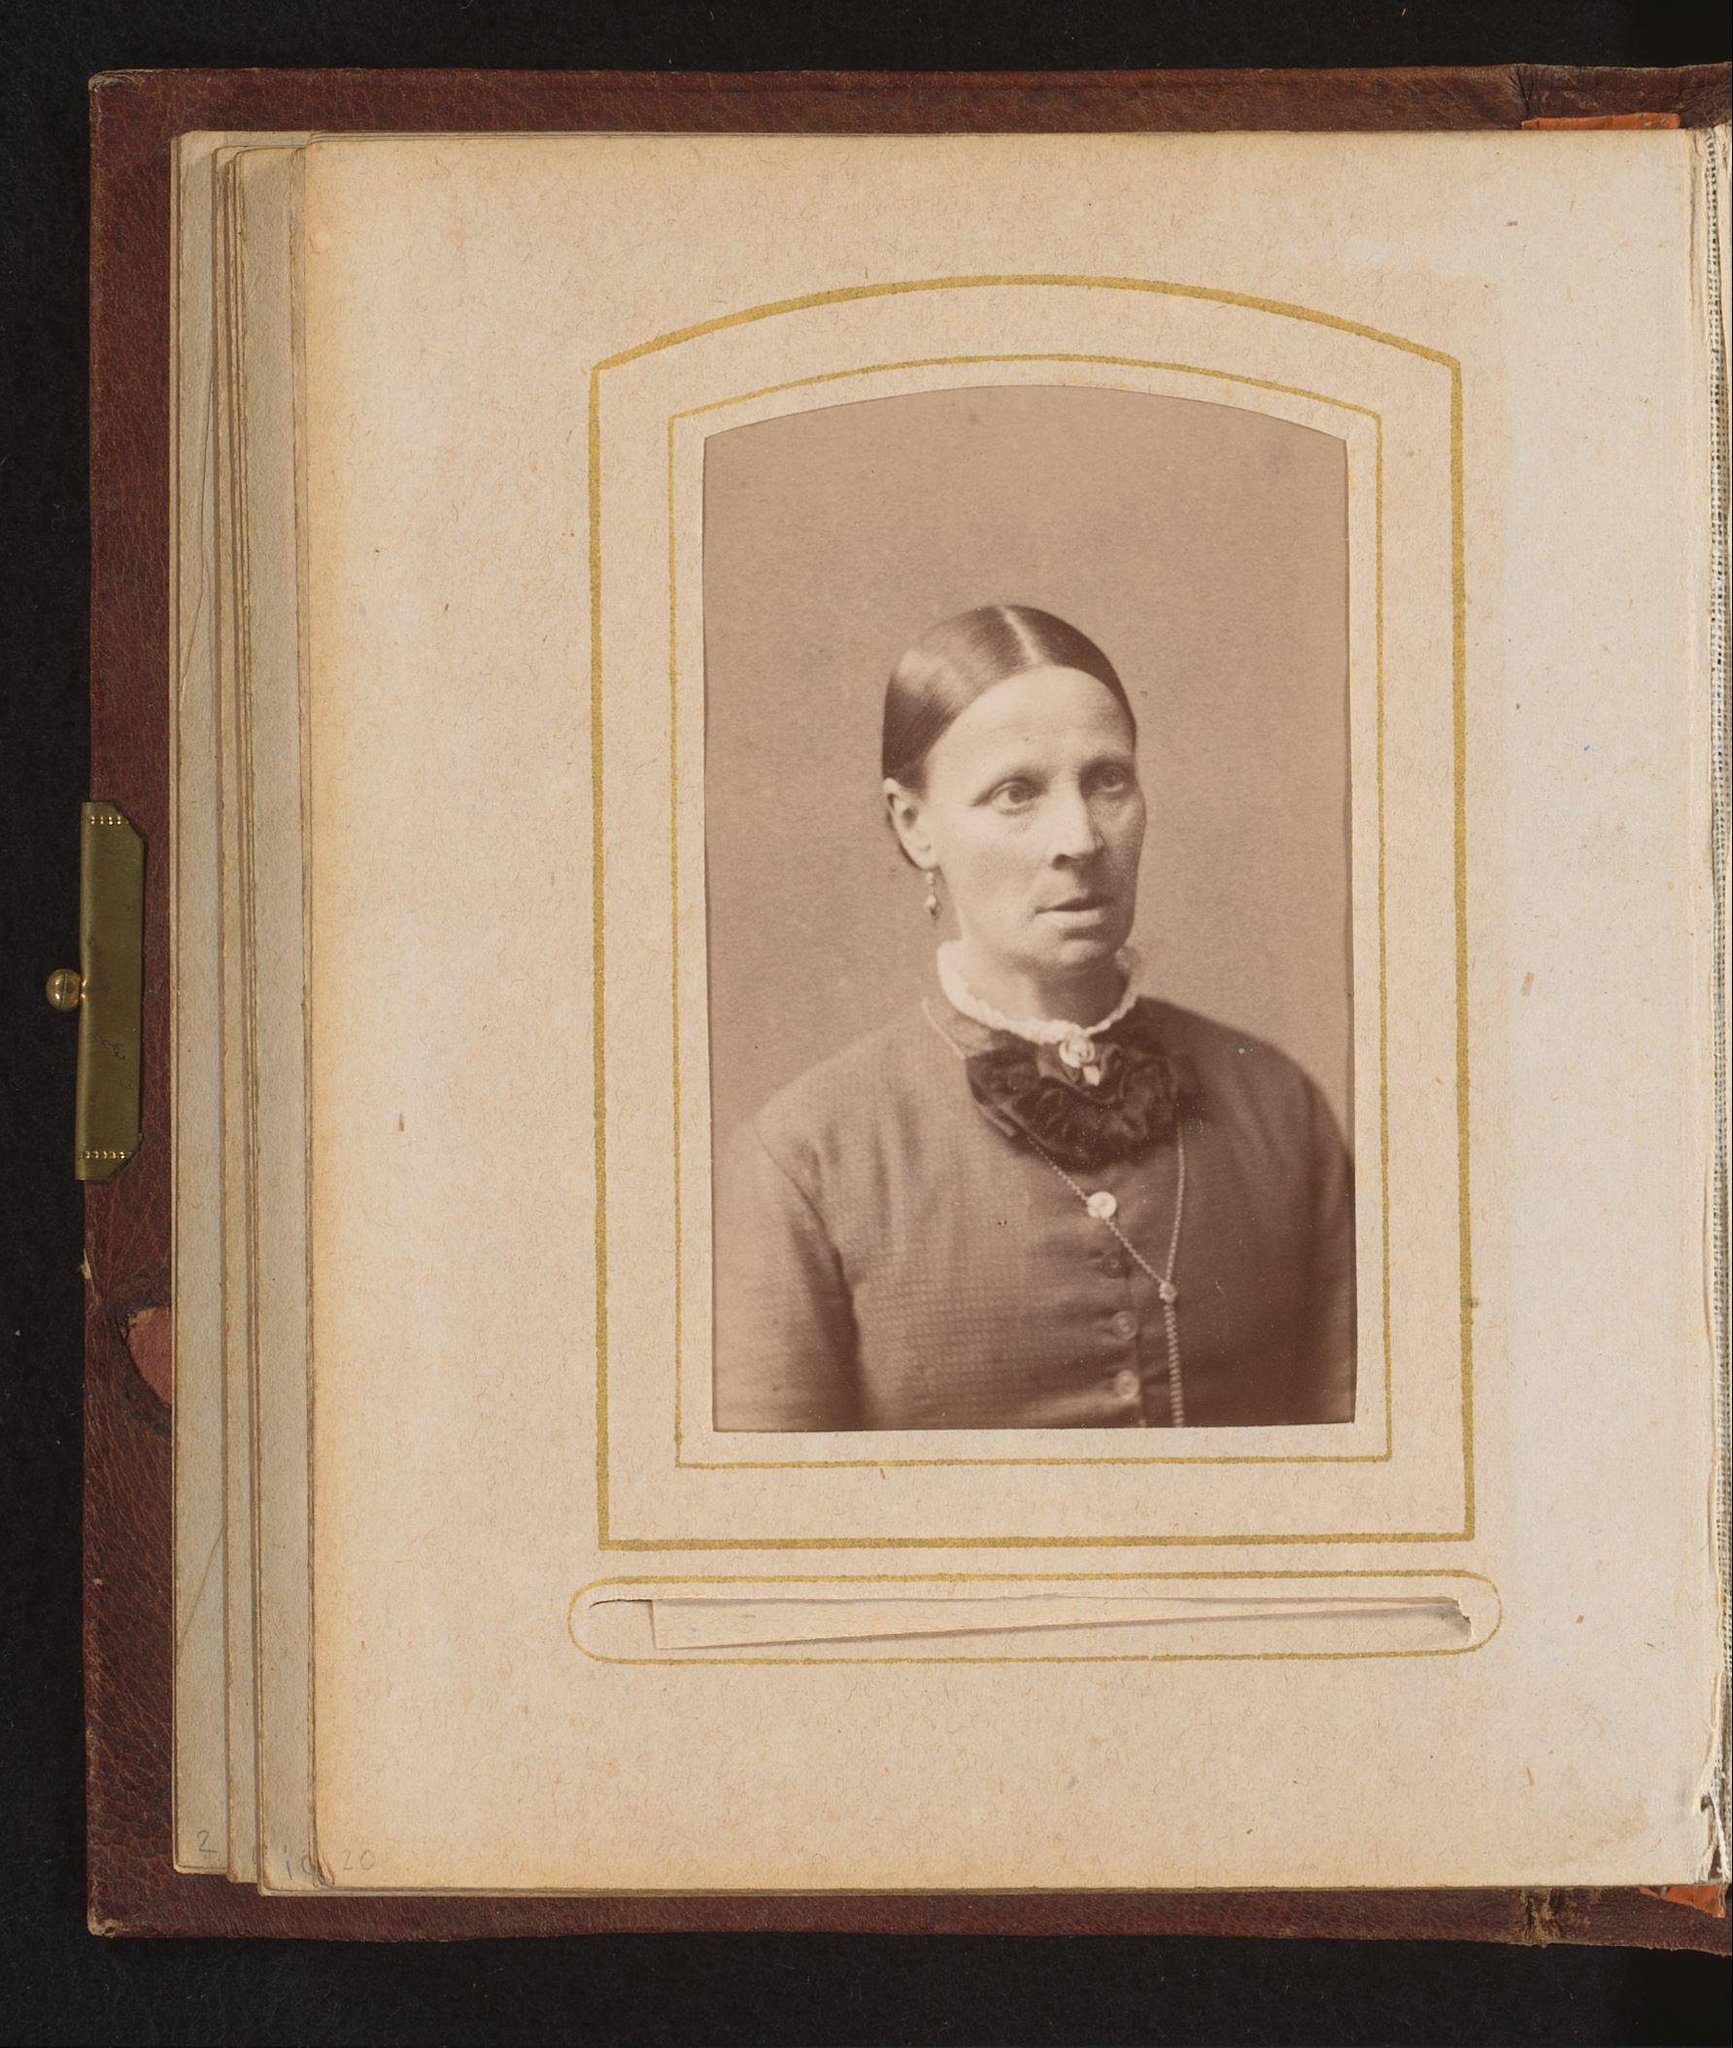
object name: photograph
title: Portret van een vrouw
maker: dirk niekerk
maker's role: fotograaf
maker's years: 1824-1881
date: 1879-1881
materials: cardboard, photographic support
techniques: albumen print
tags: adult woman, historical persons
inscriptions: inscription: ‘D. Niekerk/ (...)/ Baangracht tusschen/ Leidsche Plein en/ Kruisstraat/ 248/ Amsterdam’